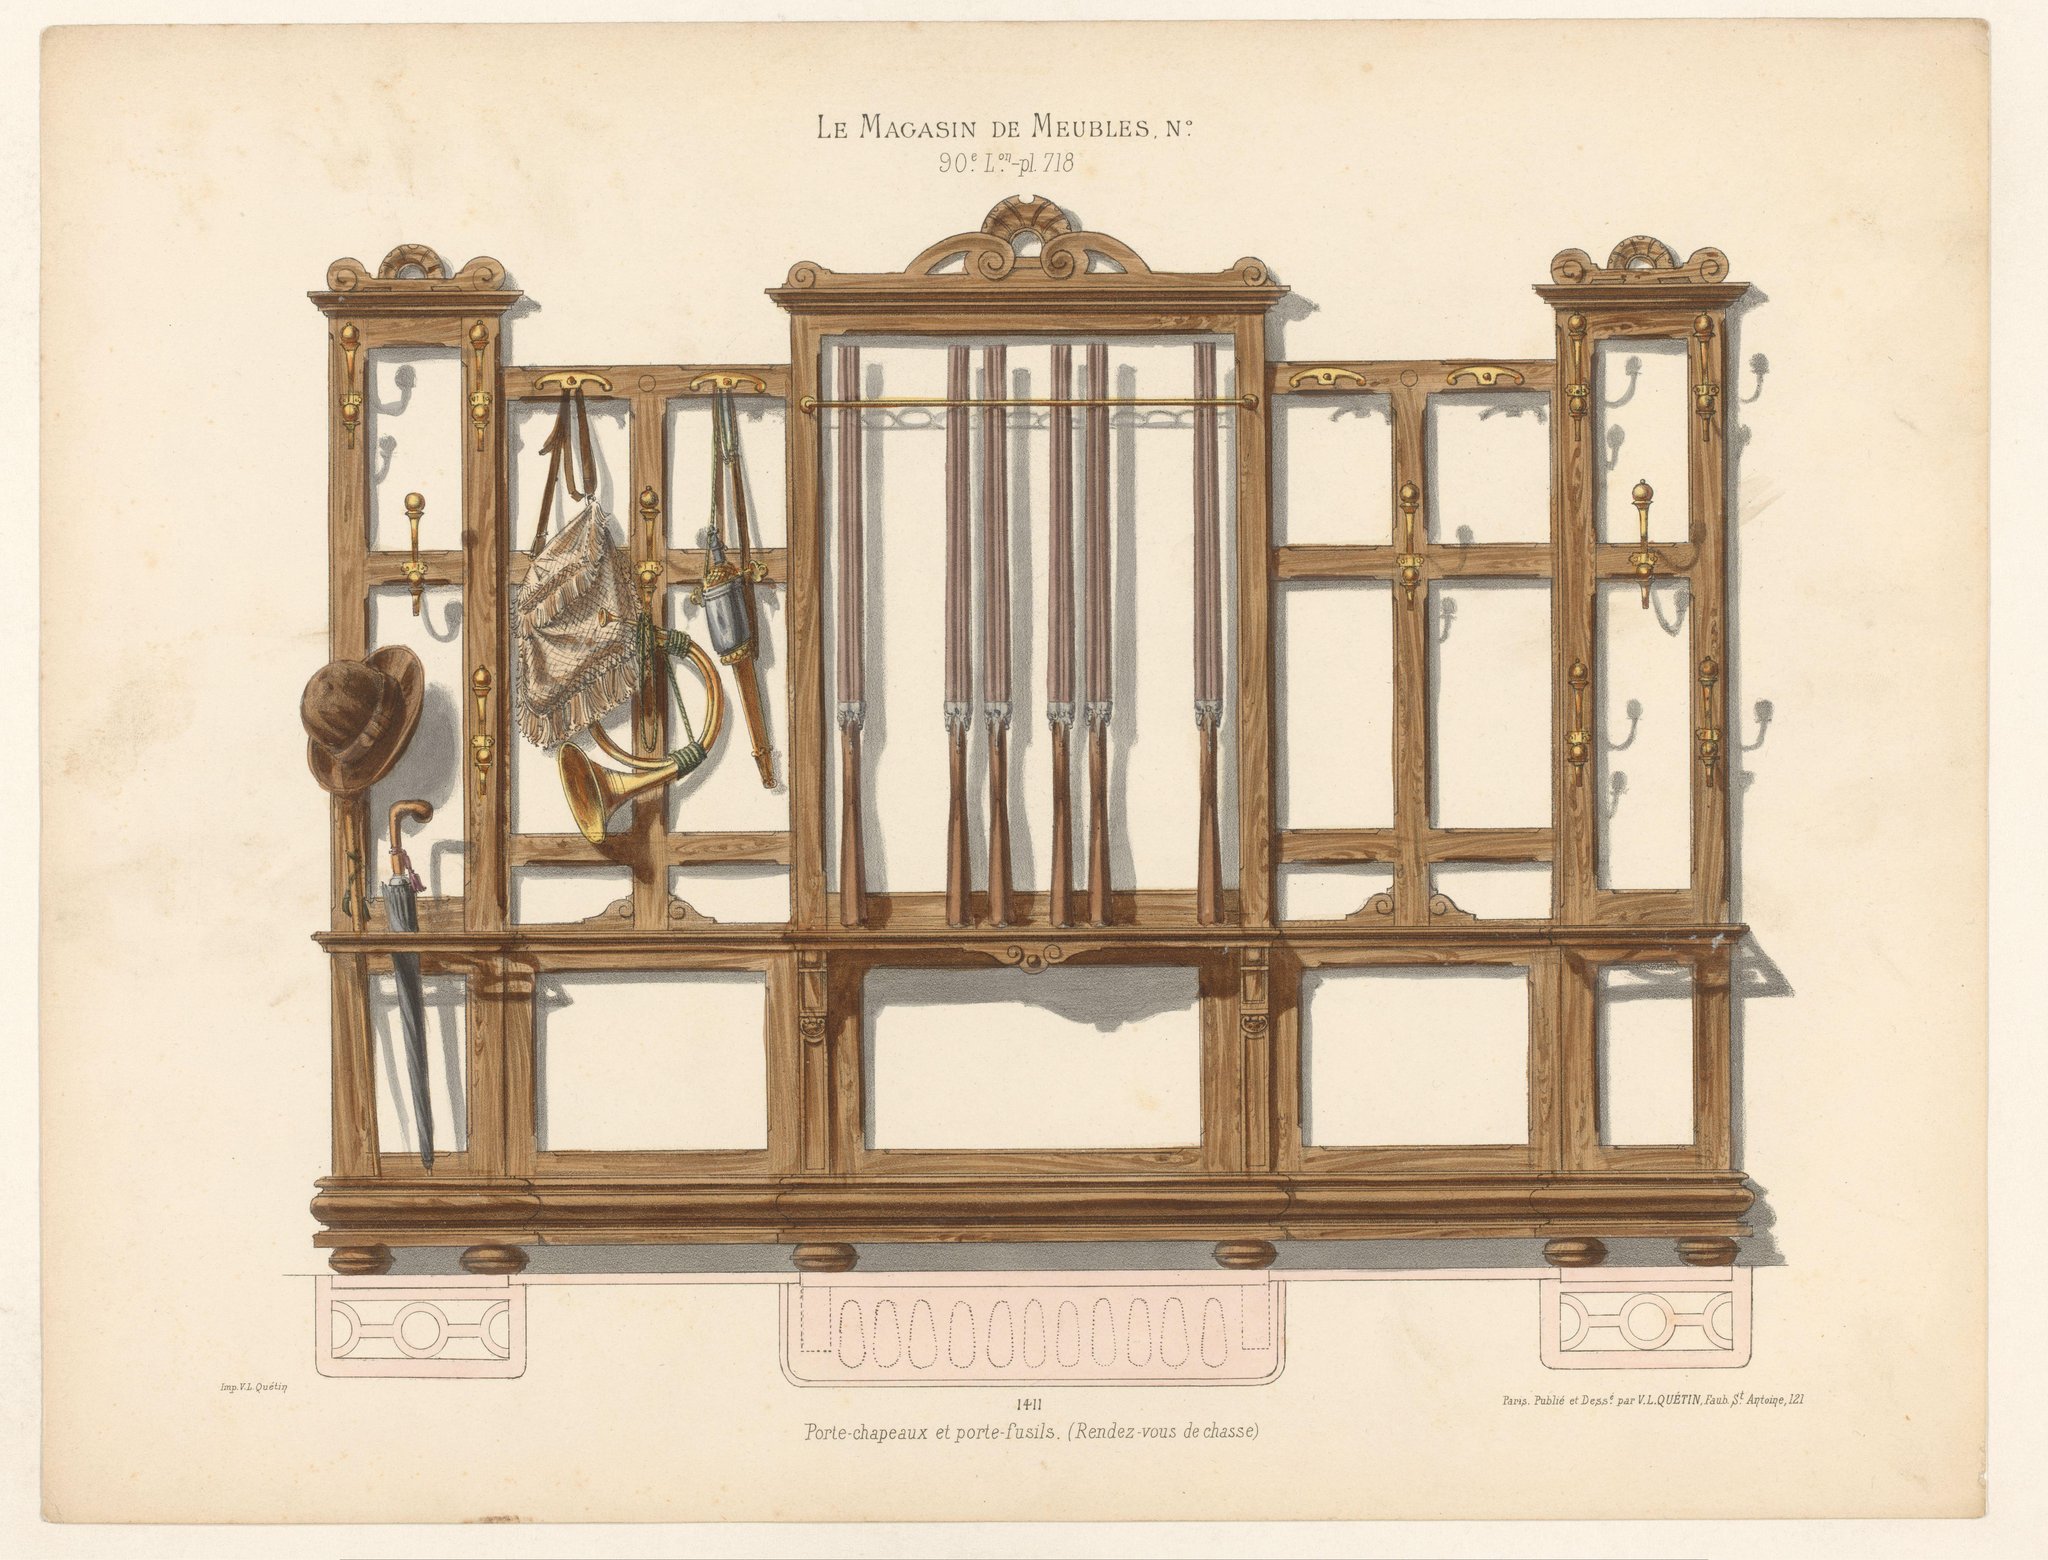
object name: print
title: Meubel met kapstokken en jachtattributen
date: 1878-1904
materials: paper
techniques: hand coloring, lithograph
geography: paris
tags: hanging clothes, hunting accoutrement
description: Een meubel met kapstokken, een standaard voor geweren en jachtattributen. Prent uit 90e Livraison.